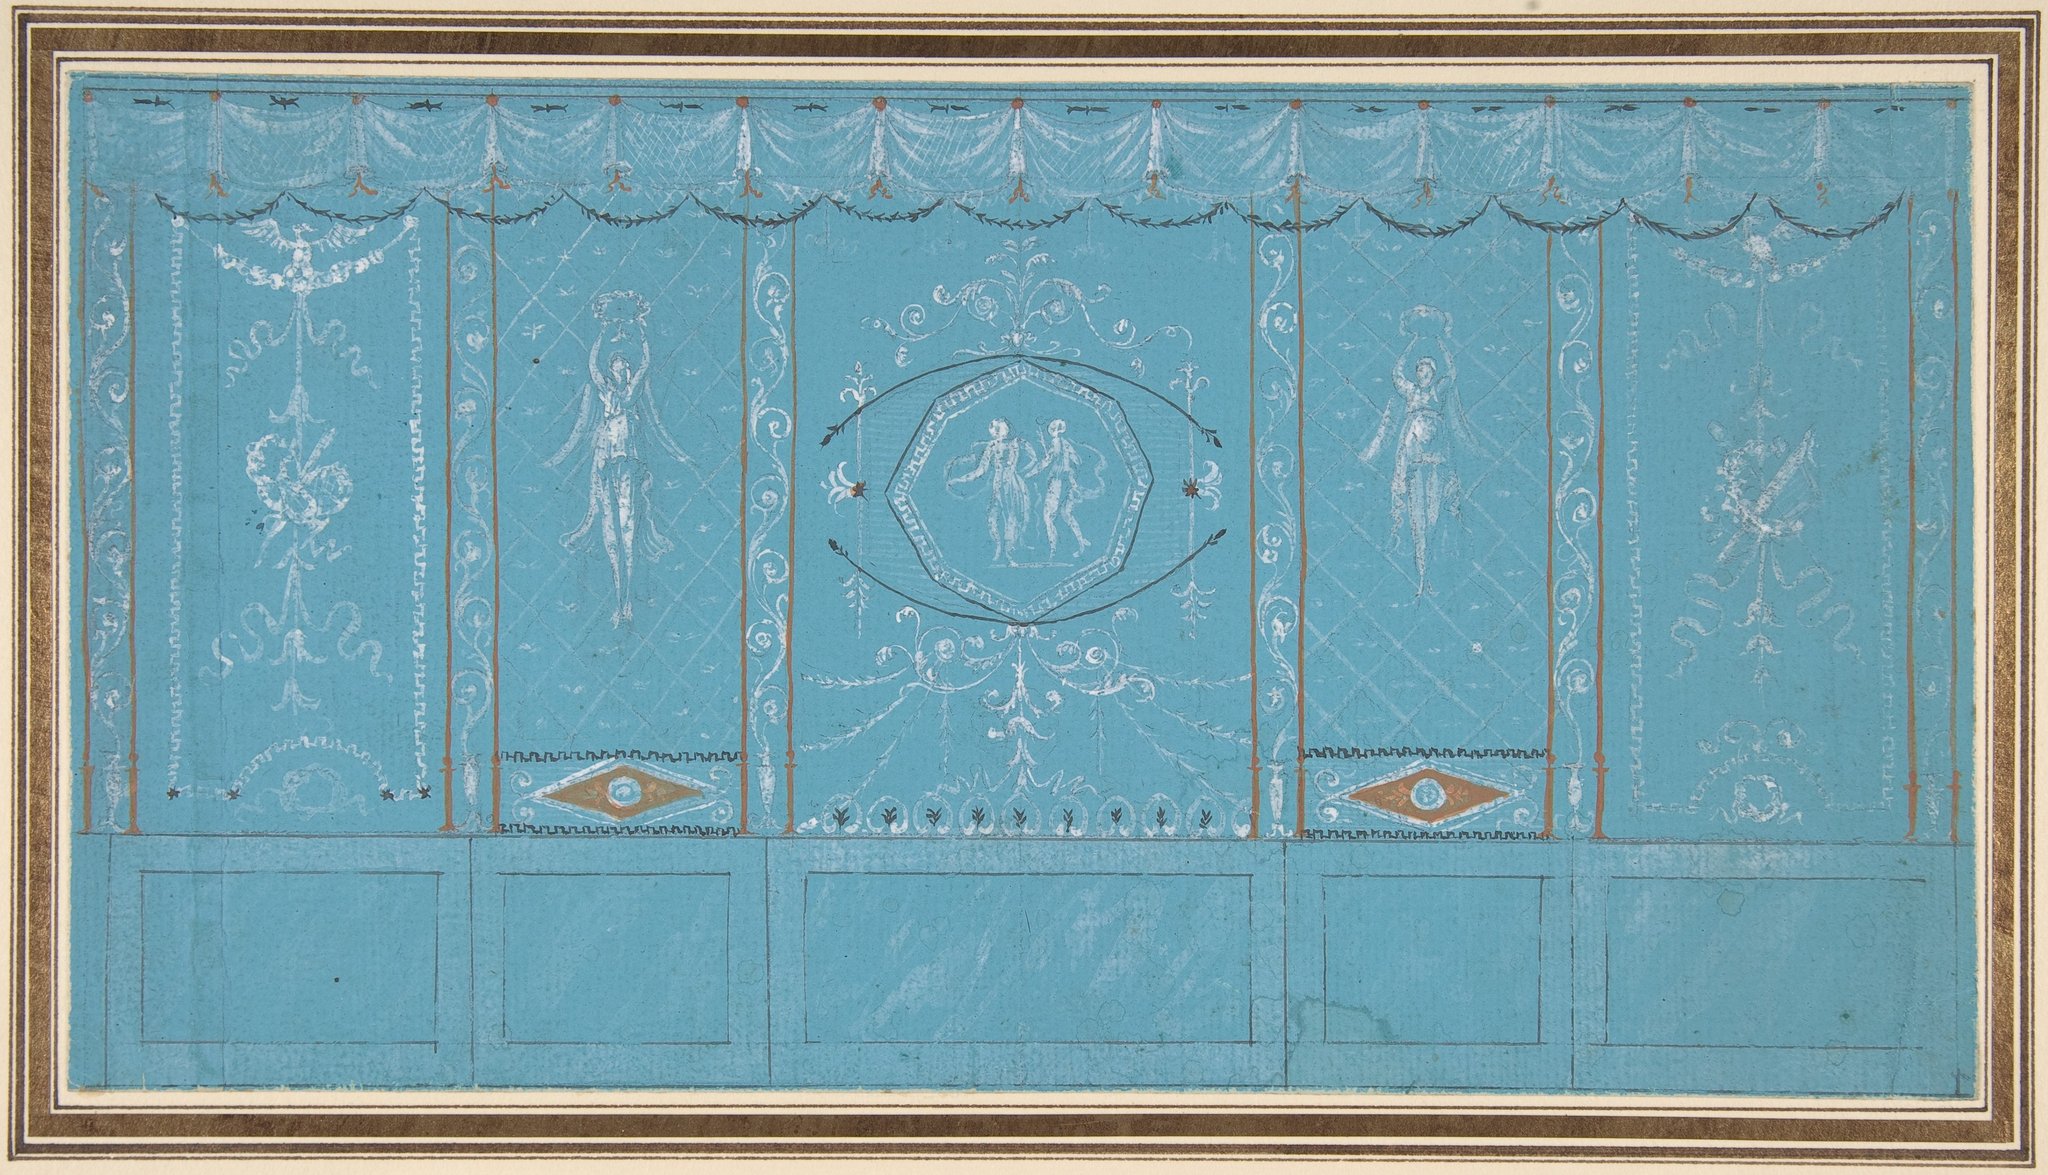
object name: drawing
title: Design for a Decorated Wall with Grottesque over Blue Background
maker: giuseppe bernardino bison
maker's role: artist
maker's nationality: italian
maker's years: 1762-1844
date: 1762-1844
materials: gold, gouache, ink, drawing material, paper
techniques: brush, pen, wash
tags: grotesques,ornament